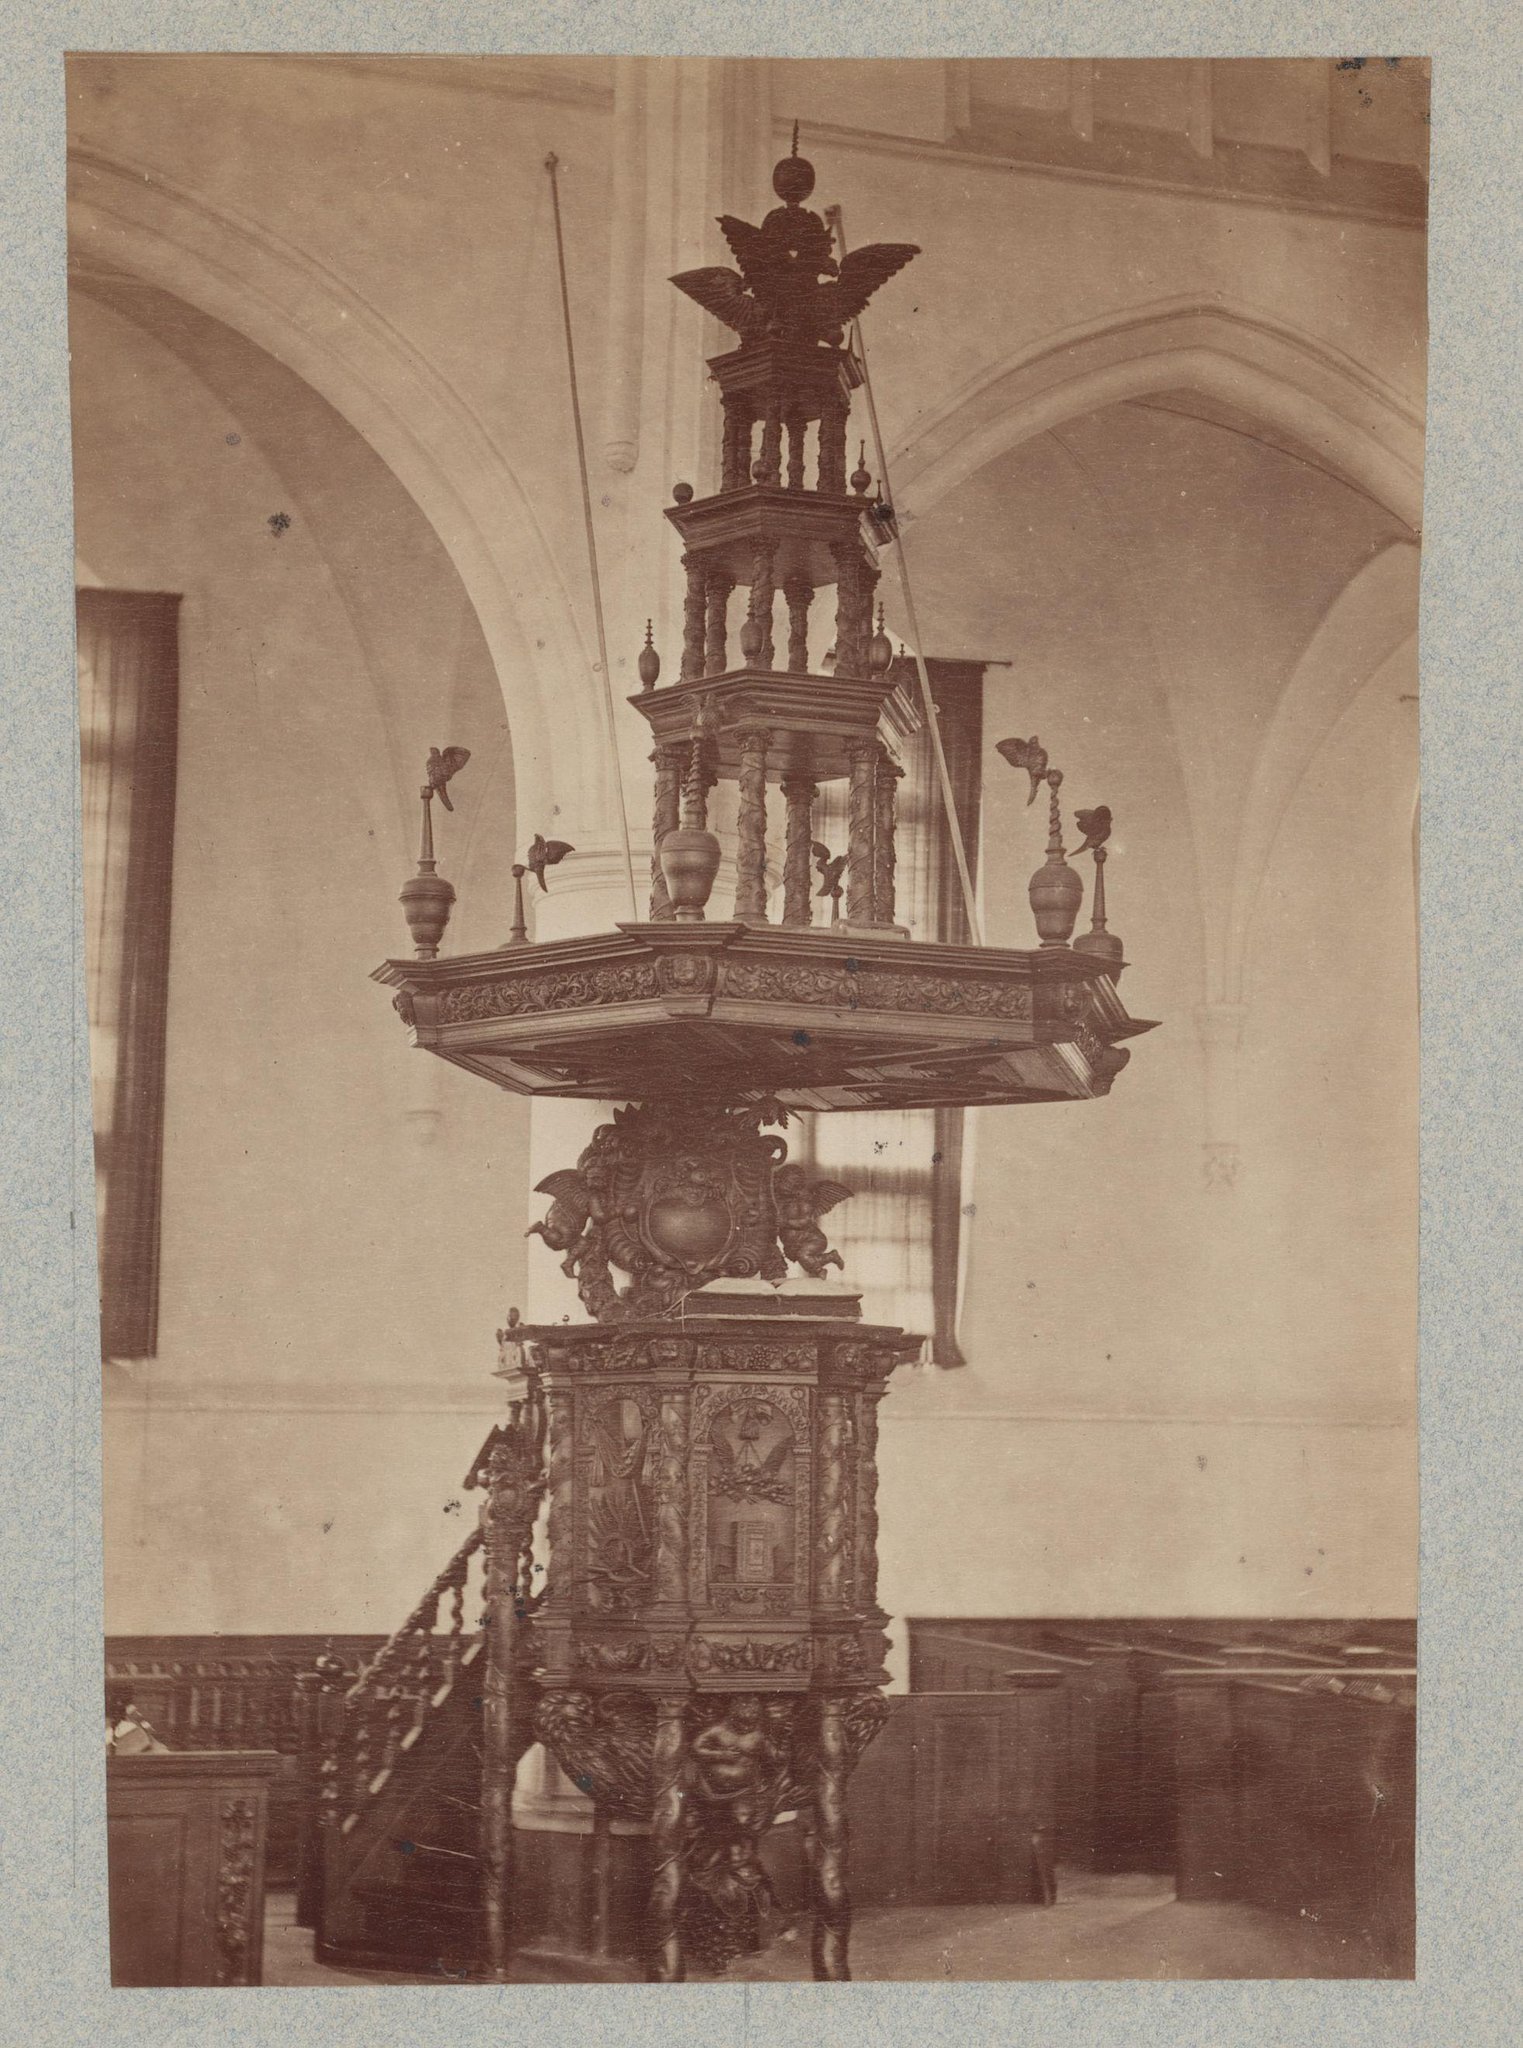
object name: photograph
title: Het preekgestoelte in een kerk in noord Nederland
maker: Anonymous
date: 1870-1900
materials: cardboard, photographic support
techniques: albumen print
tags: seats of the clergy, choir-stalls